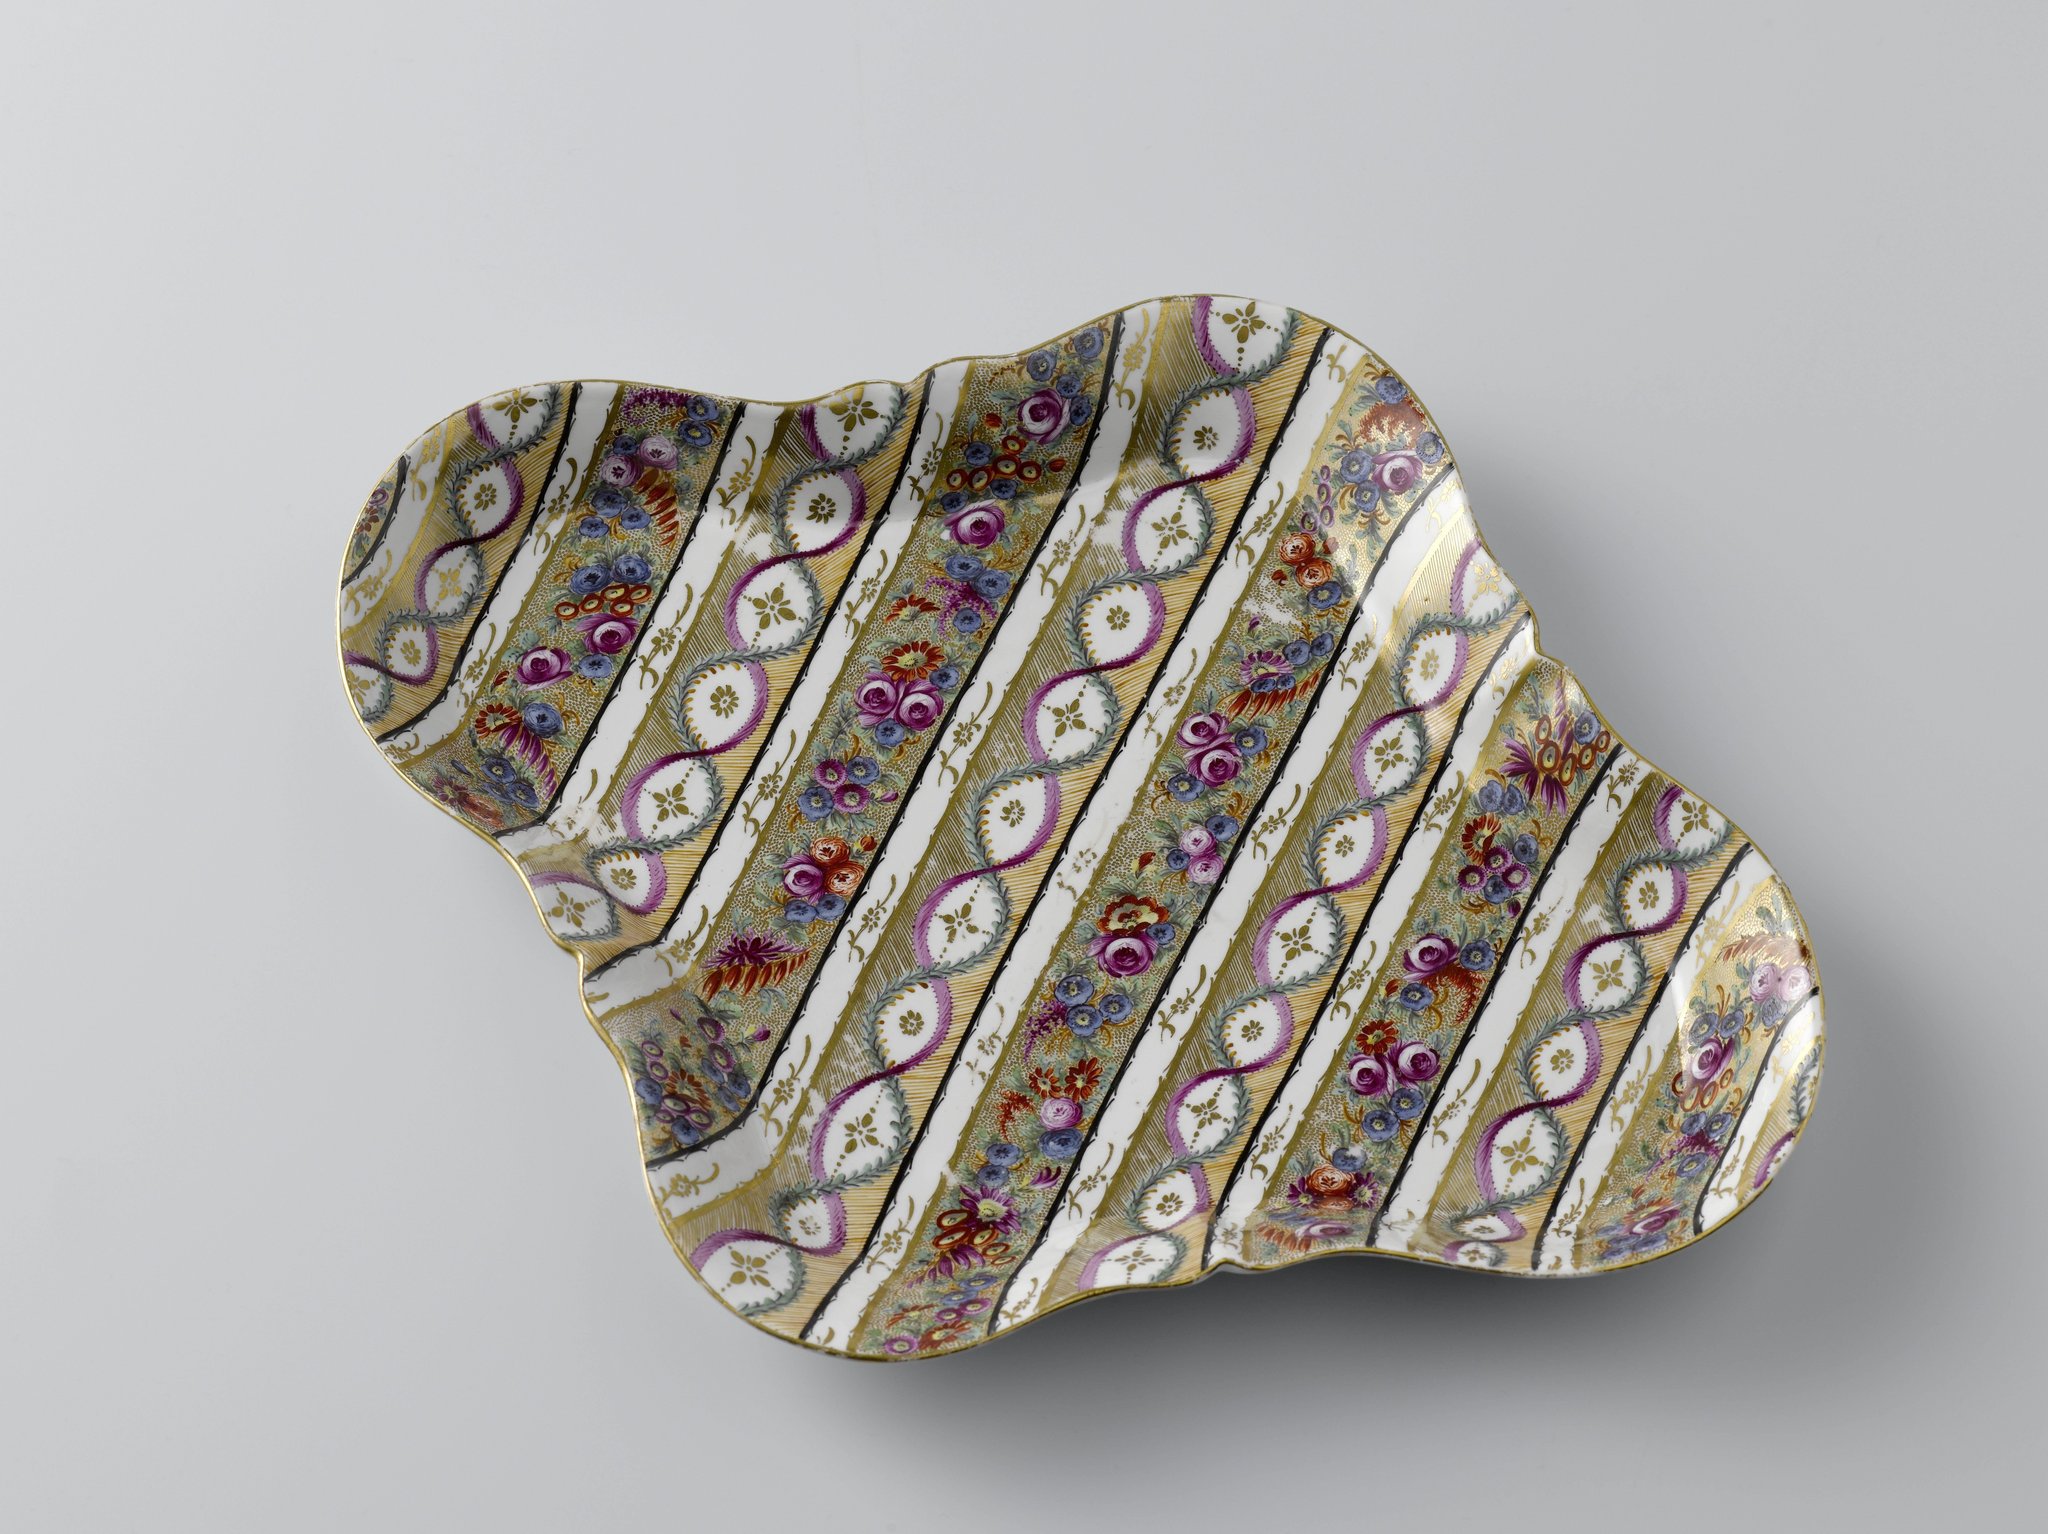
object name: tea service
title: Dish or tray with ornamental borders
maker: louis victor gerverot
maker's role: ceramicist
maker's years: 1747-1829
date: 1773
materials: glaze, gold, paint, porcelain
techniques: firing, forming, gilding, vitrification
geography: schrezheim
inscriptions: mark: ‘M/ g’, inscription: ‘OL. 12 Novbr 1773. // J.D.M. ~’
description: Viermaal gelobd blad of schotel van porselein, beschilderd op het glazuur in blauw, rood, roze, groen, geel, zwart en goud. De voorzijde is verdeeld in rechte banden afwisselend gevuld met bloemranken, elkaar snijdende bladranken waarbinnen een rozet en smalle banden met gouden bloemtakken. Gemerkt op de onderzijde met een schild met M, waaronder een g en OL. 12 Novbr 1773. // J.D.M. ~.